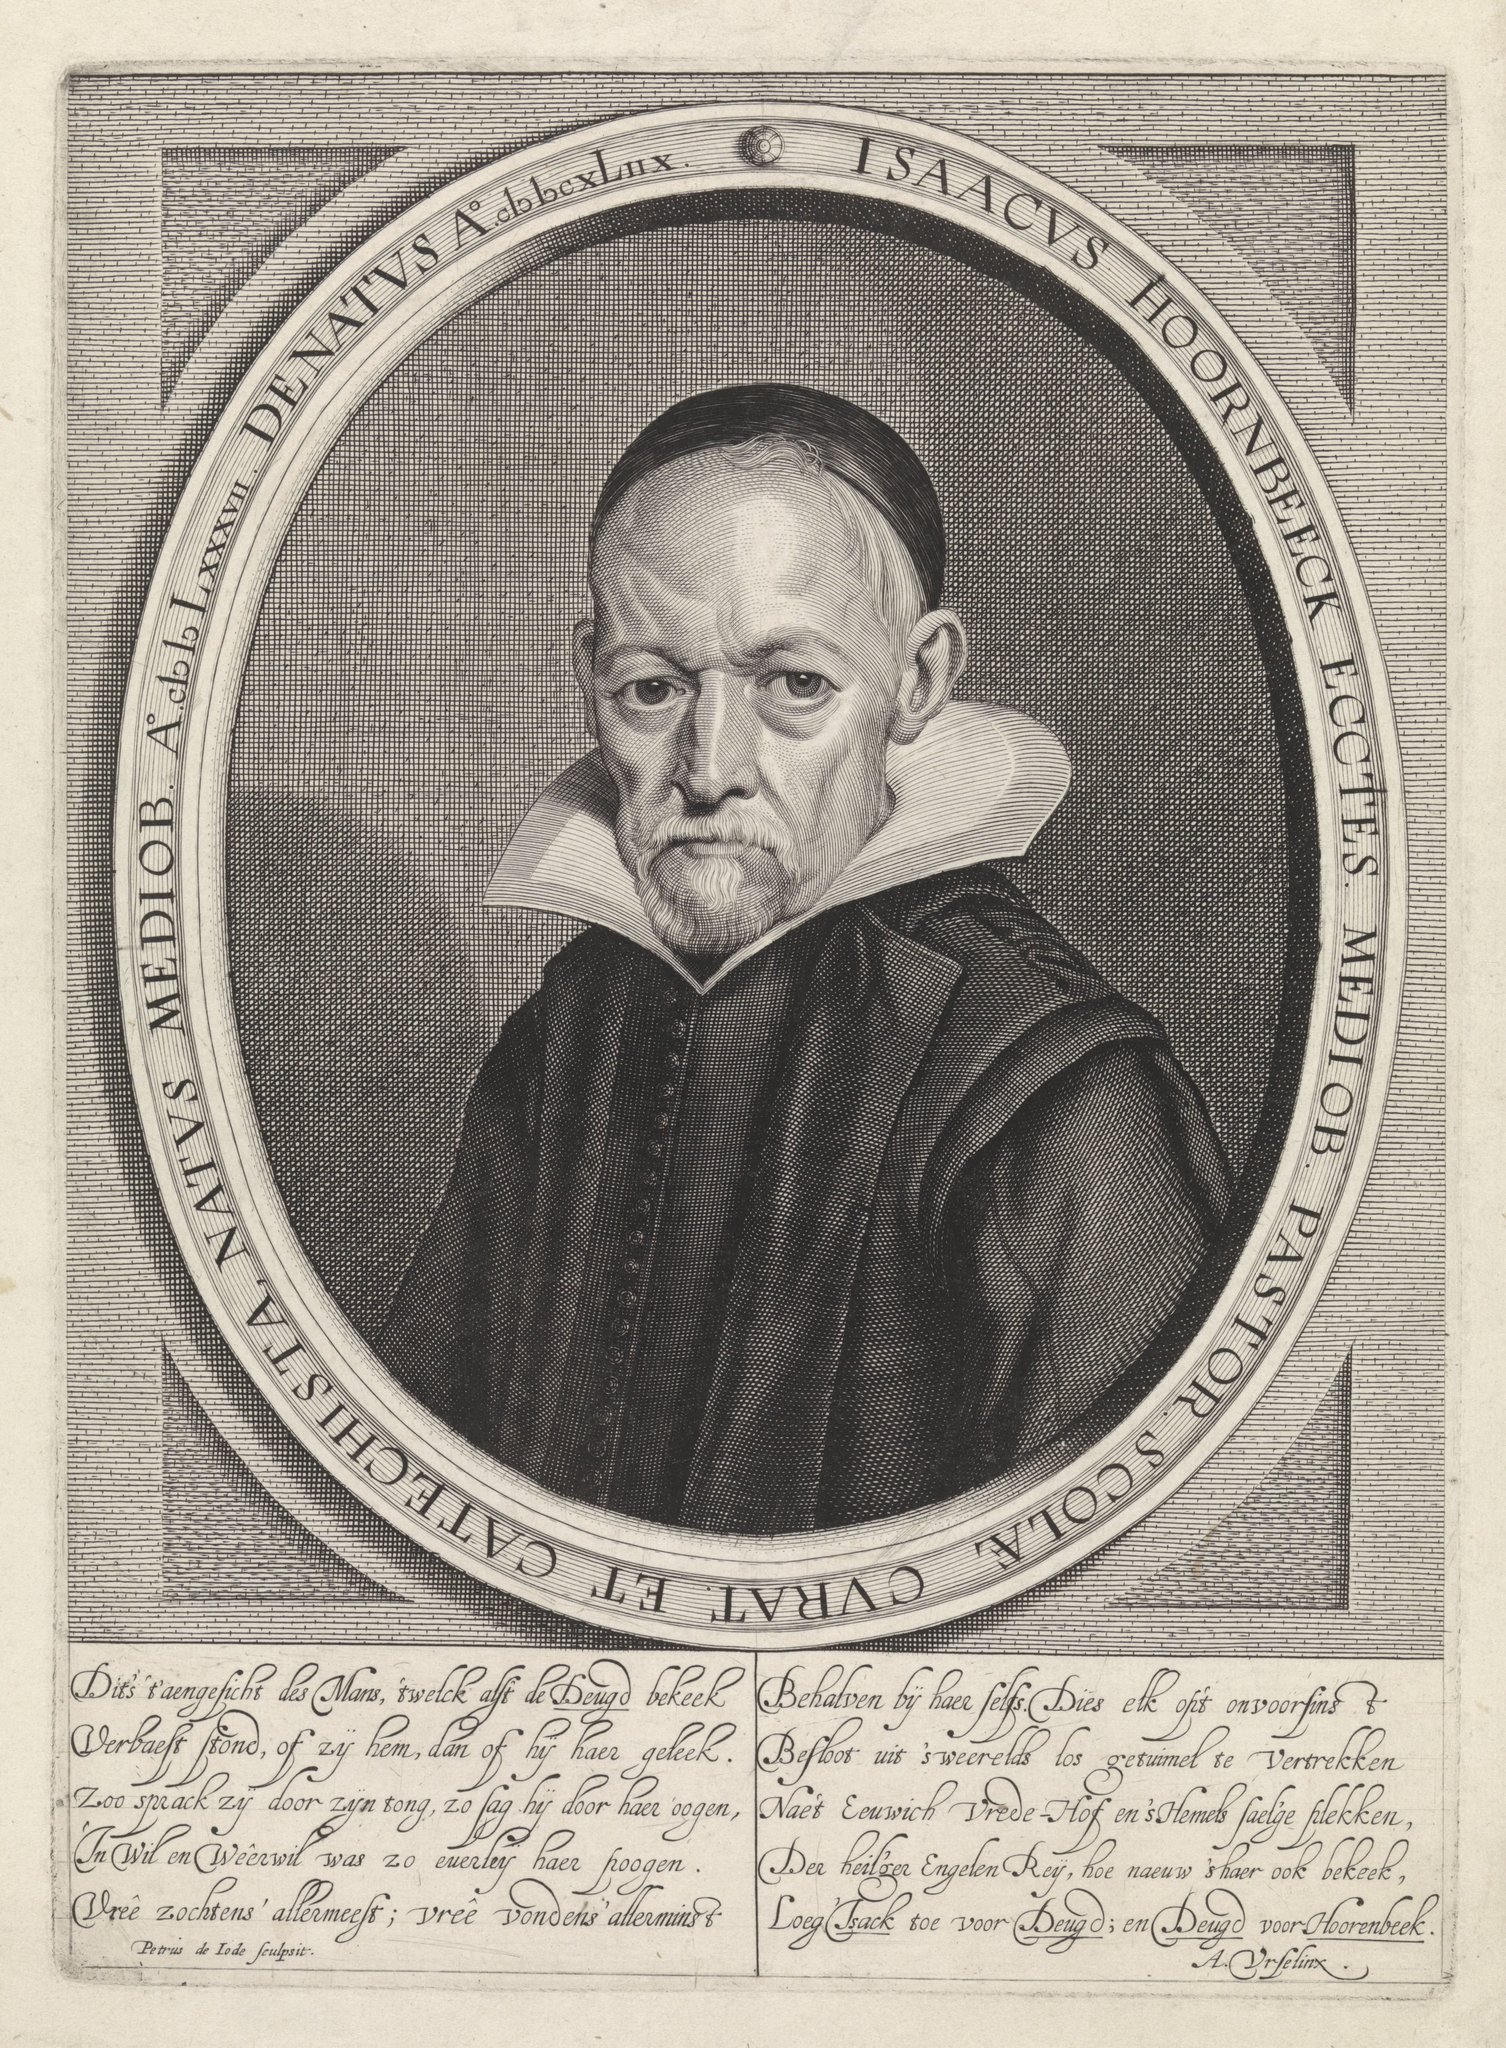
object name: print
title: Portret van Isaac Hoornbeeck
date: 1628-1670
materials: paper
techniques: engraving, etching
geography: antwerp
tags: predikant, isaac hoornbeeck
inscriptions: collector's mark: Lugt 240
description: Busteportret van de predikant Isaac Hoornbeeck, met kalot. Het portret is gevat in een ovale omlijsting met een randschrift in het Latijn. In de marge, in twee kolommen, een tienregelig gedicht in het Nederlands.